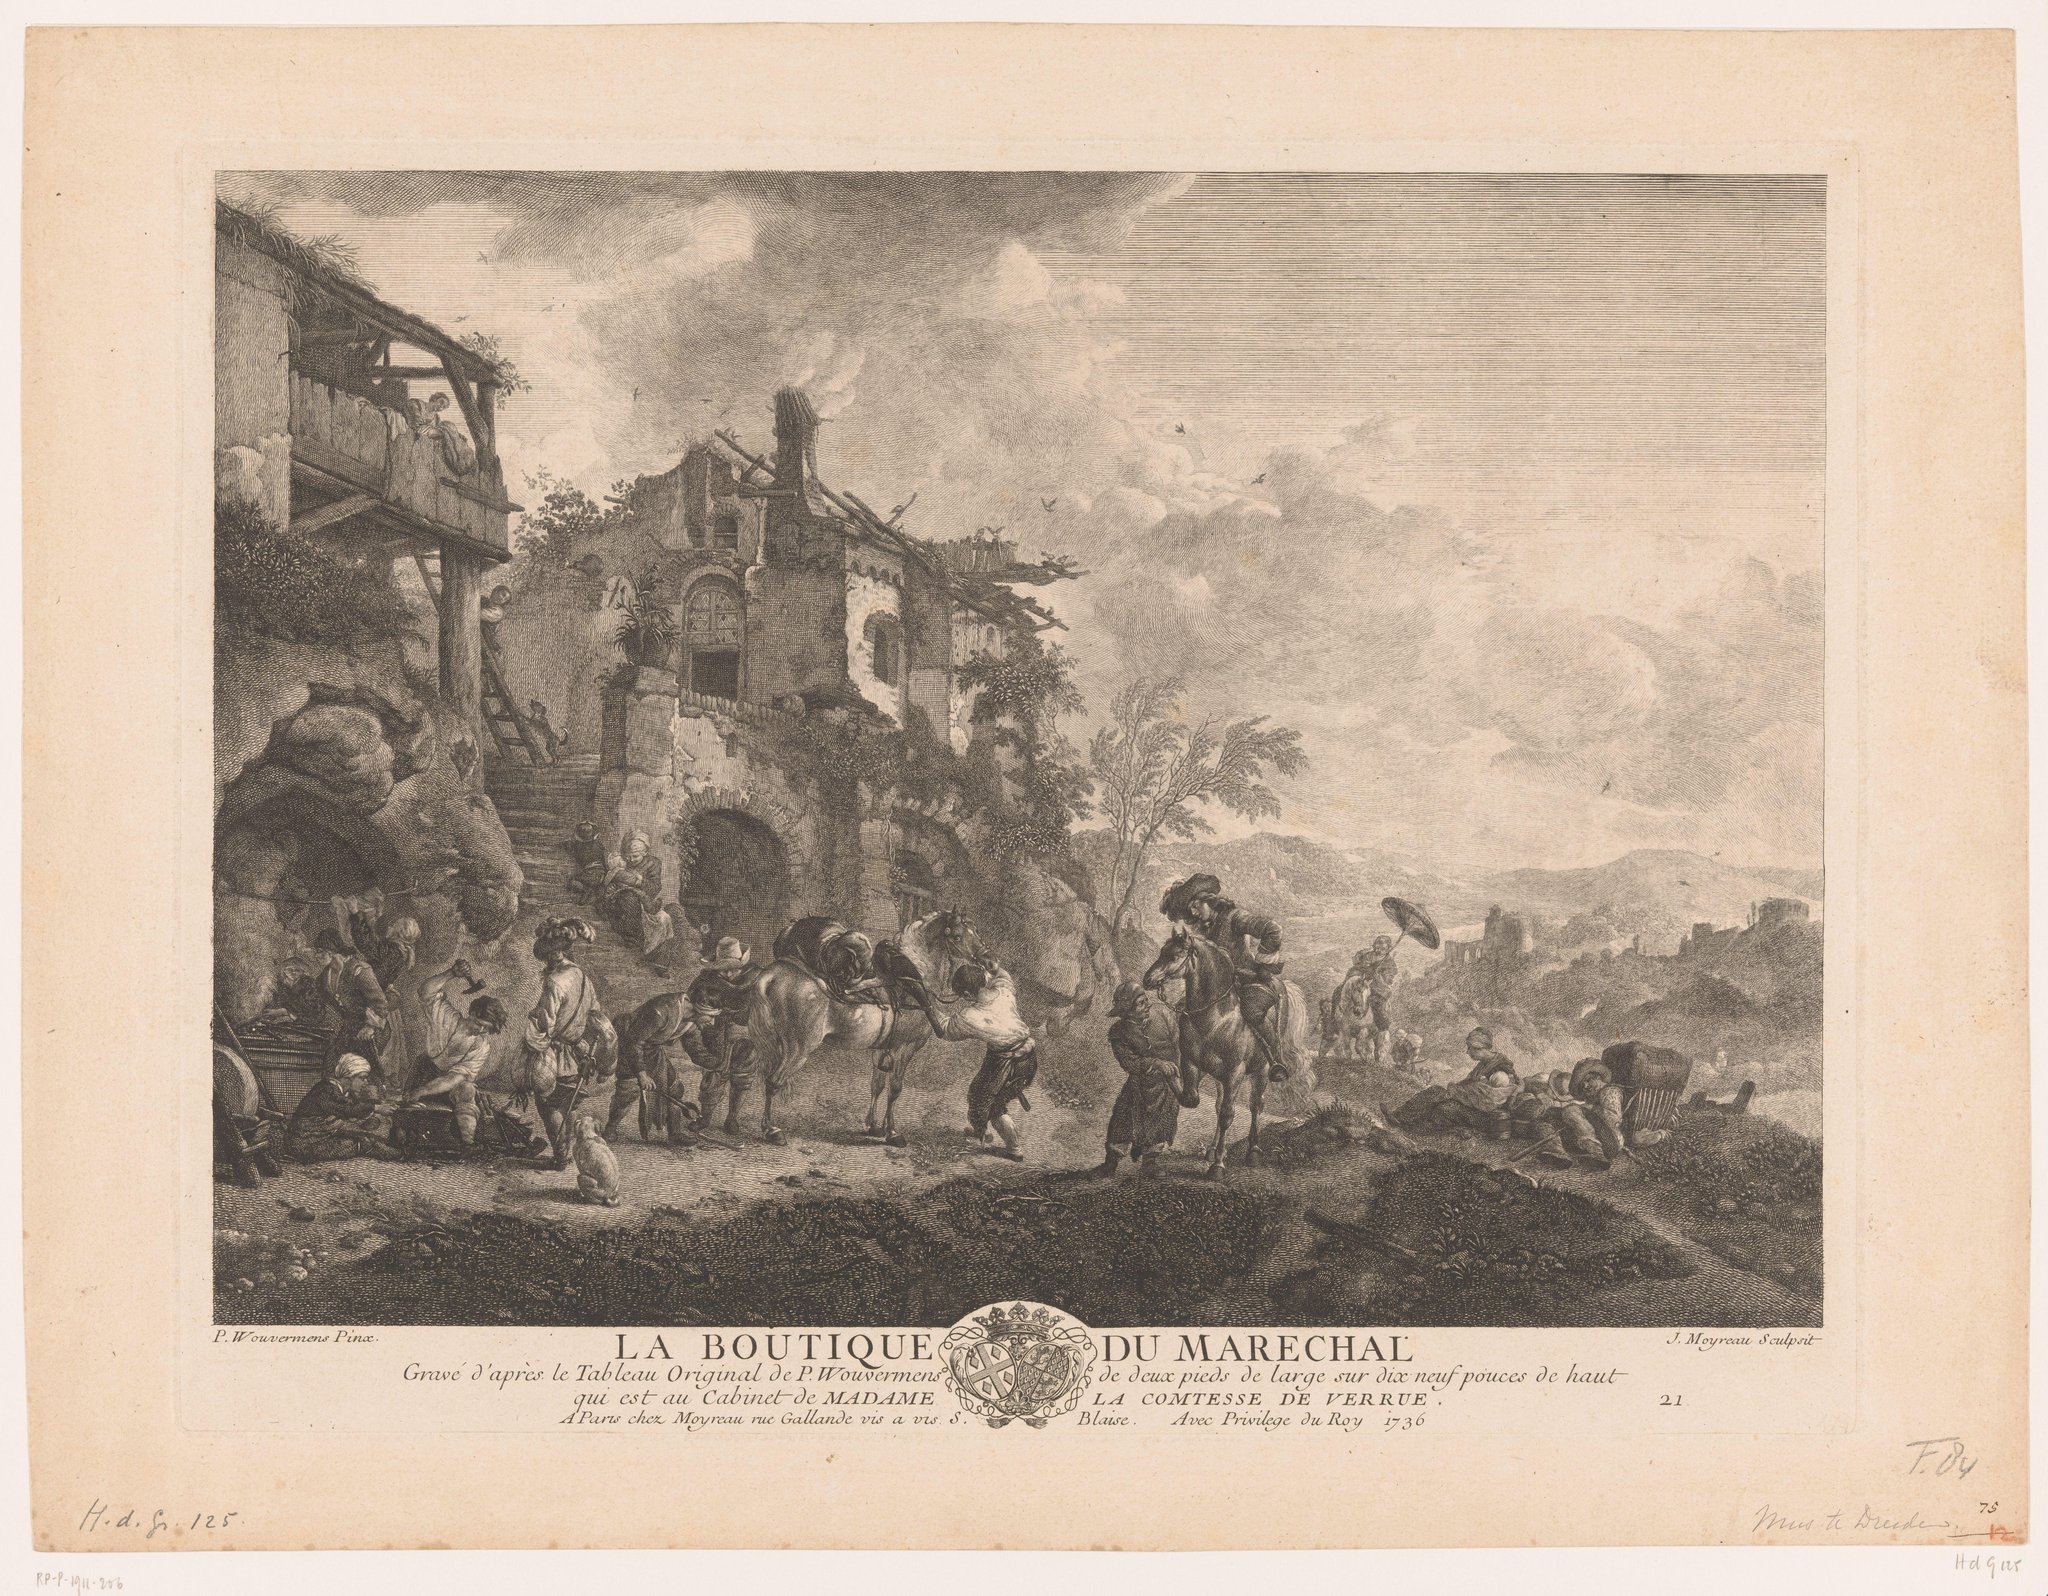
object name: print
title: La boutique du marechal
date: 1736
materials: paper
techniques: engraving, etching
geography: paris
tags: smith, blacksmith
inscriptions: collector's mark: Lugt 2228, number: ‘75’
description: Maakt deel uit van een serie van 89 prenten te dateren tussen ca. 1733-1762, naar het geschilderde oeuvre van Philips Wouwerman.